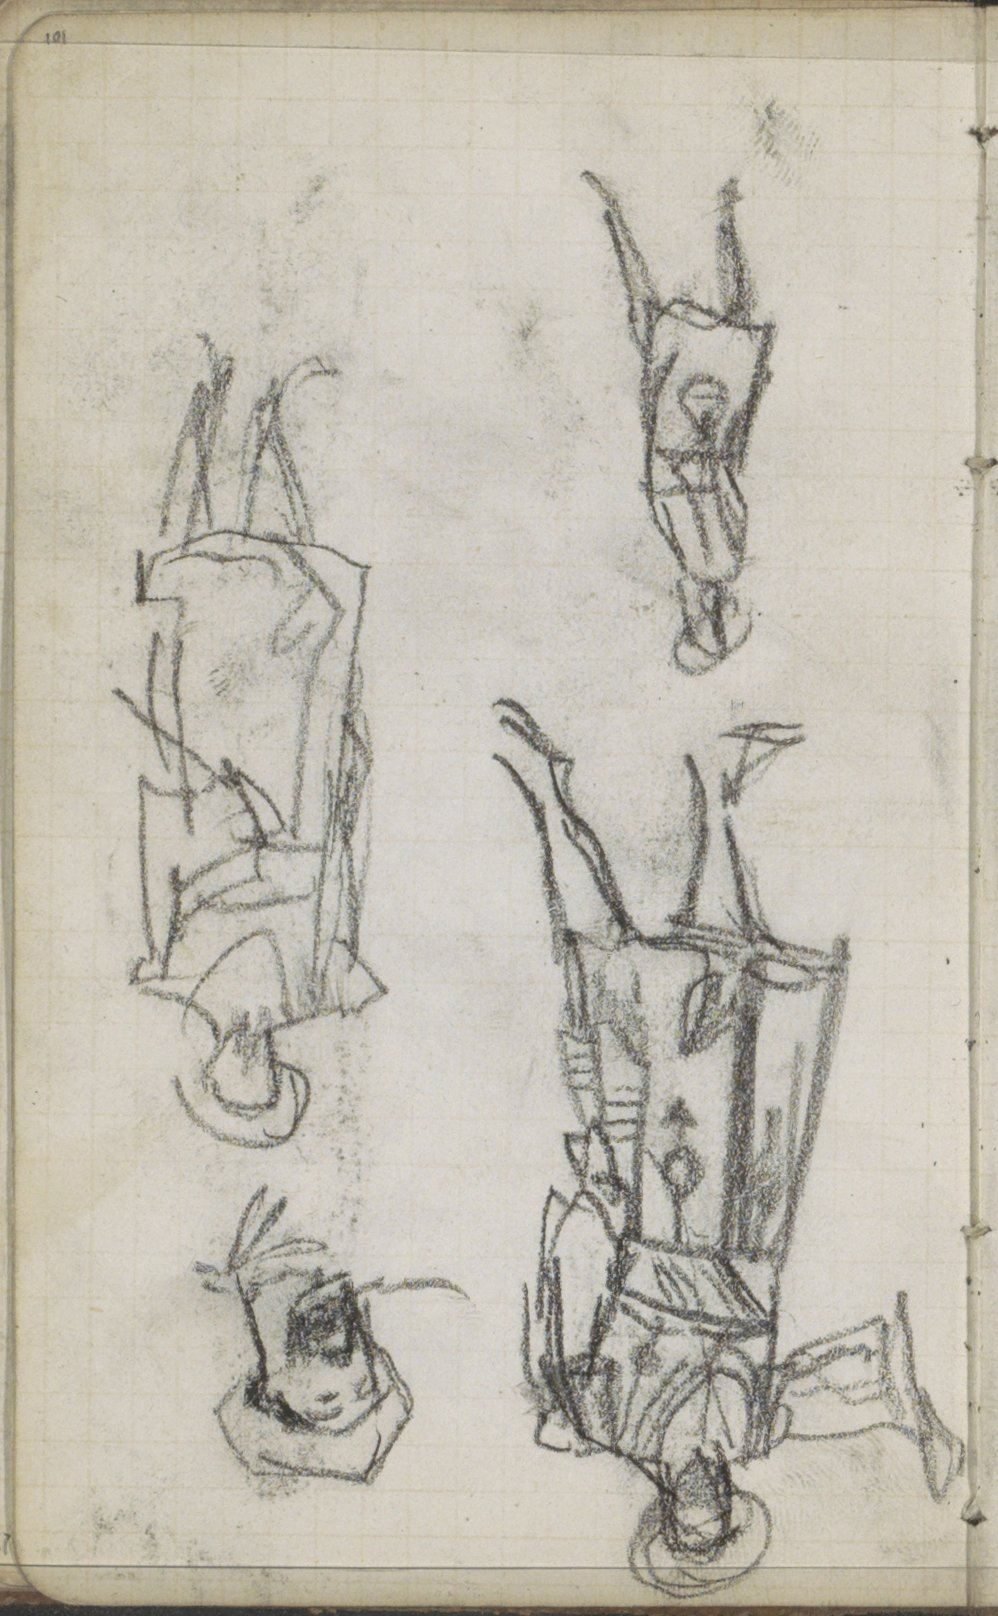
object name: sketchbook leaf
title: Mannen in historisch kostuum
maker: marius bauer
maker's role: draughtsman, print maker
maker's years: 1867-1932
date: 1879-1885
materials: chalk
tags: standing figure, adult man, historical costume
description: Mogelijk kostuums voor een theaterstuk. Pagina 101 uit een schetsboek met 58 bladen.